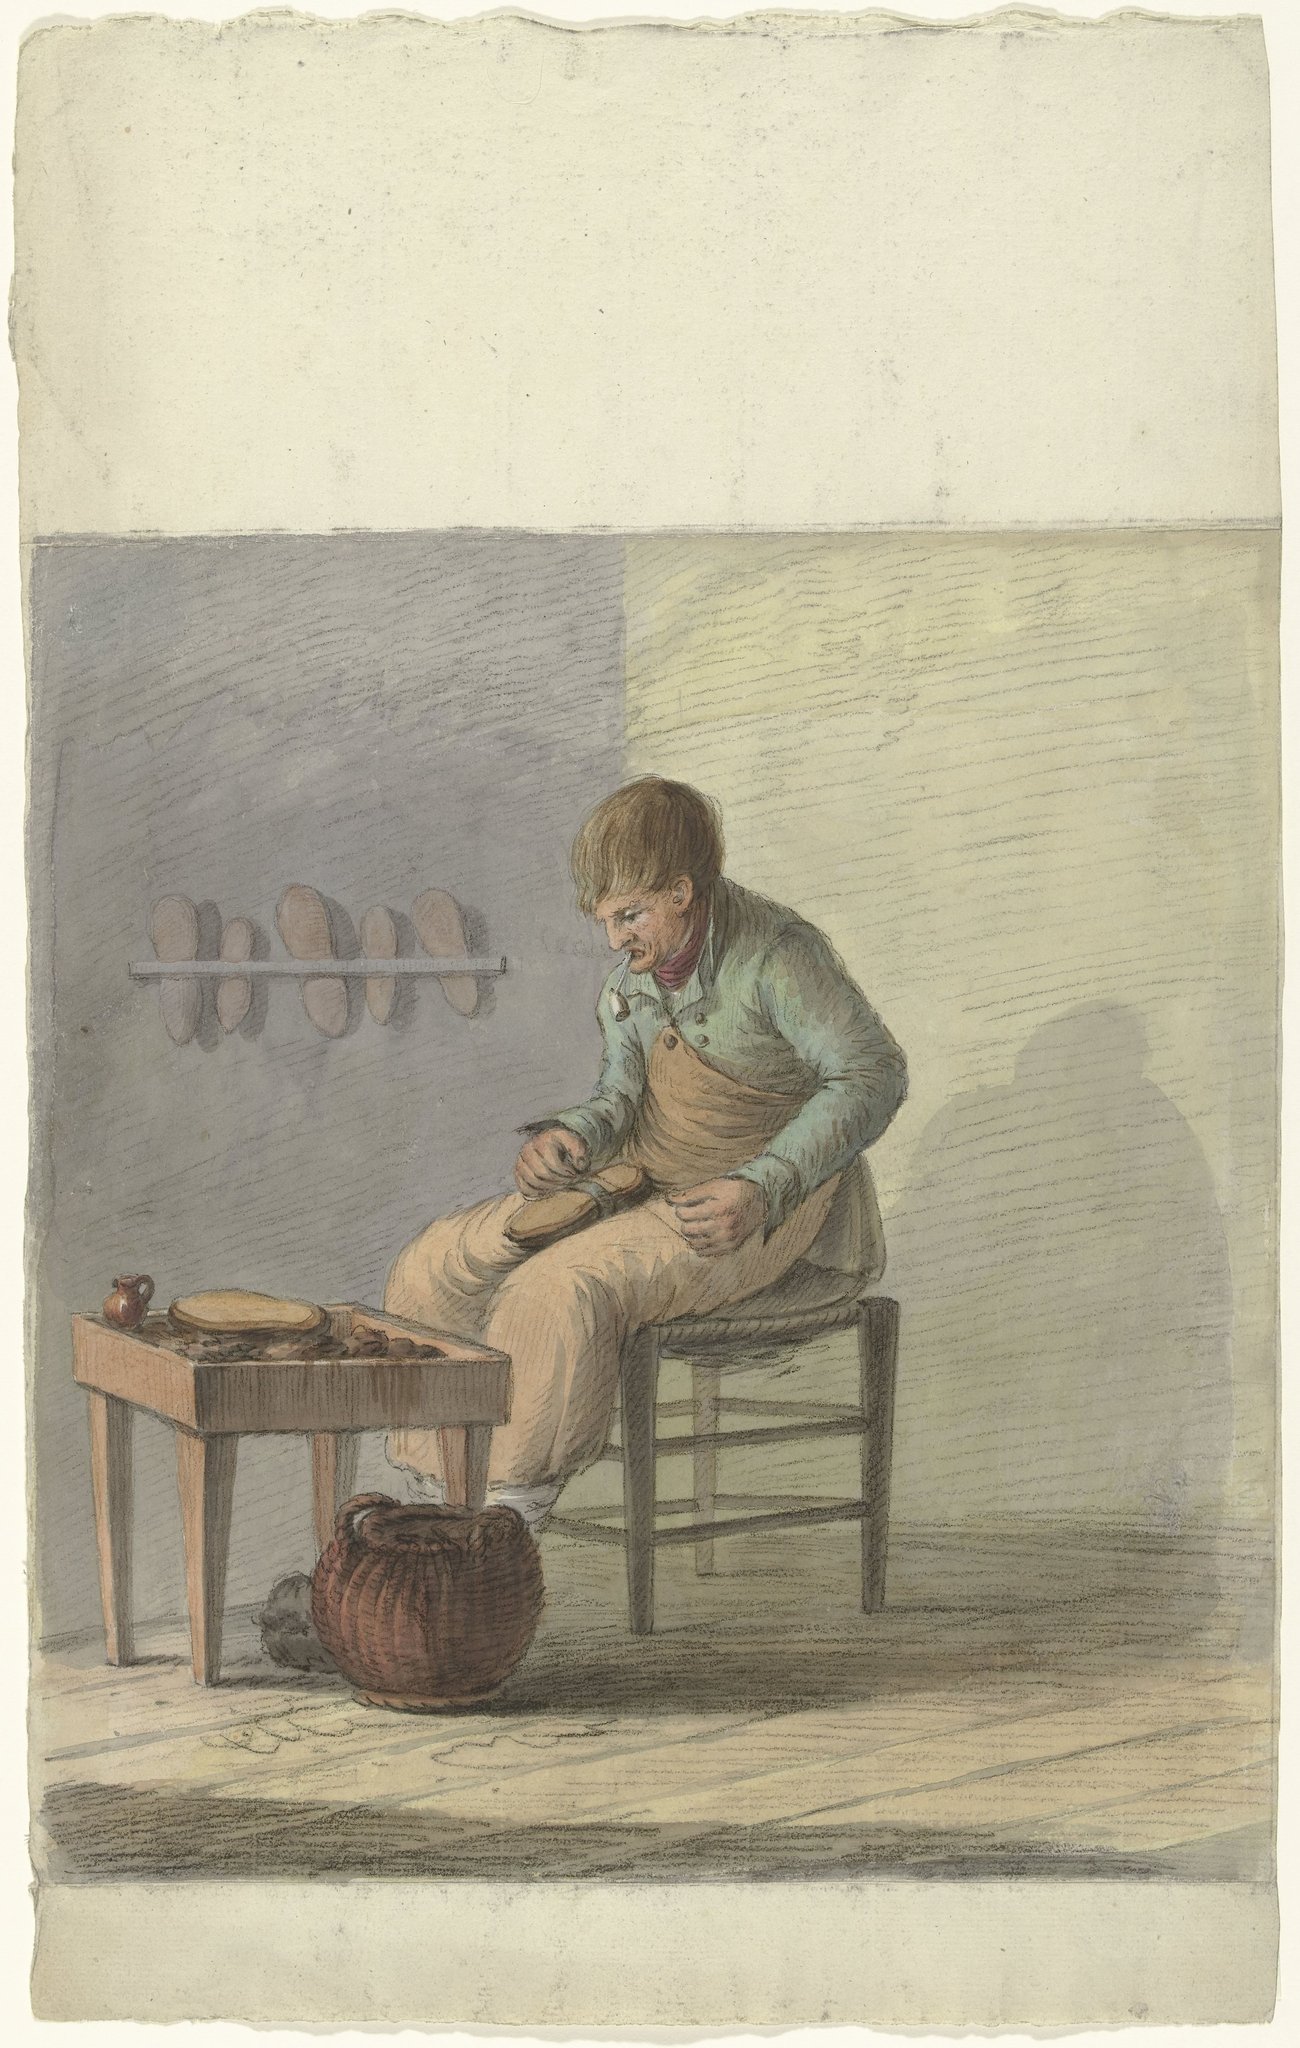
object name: drawing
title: Schoenmaker aan het werk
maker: Anonymous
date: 1700-1800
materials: chalk, paper, watercolor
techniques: brush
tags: shoe-maker, cobbler